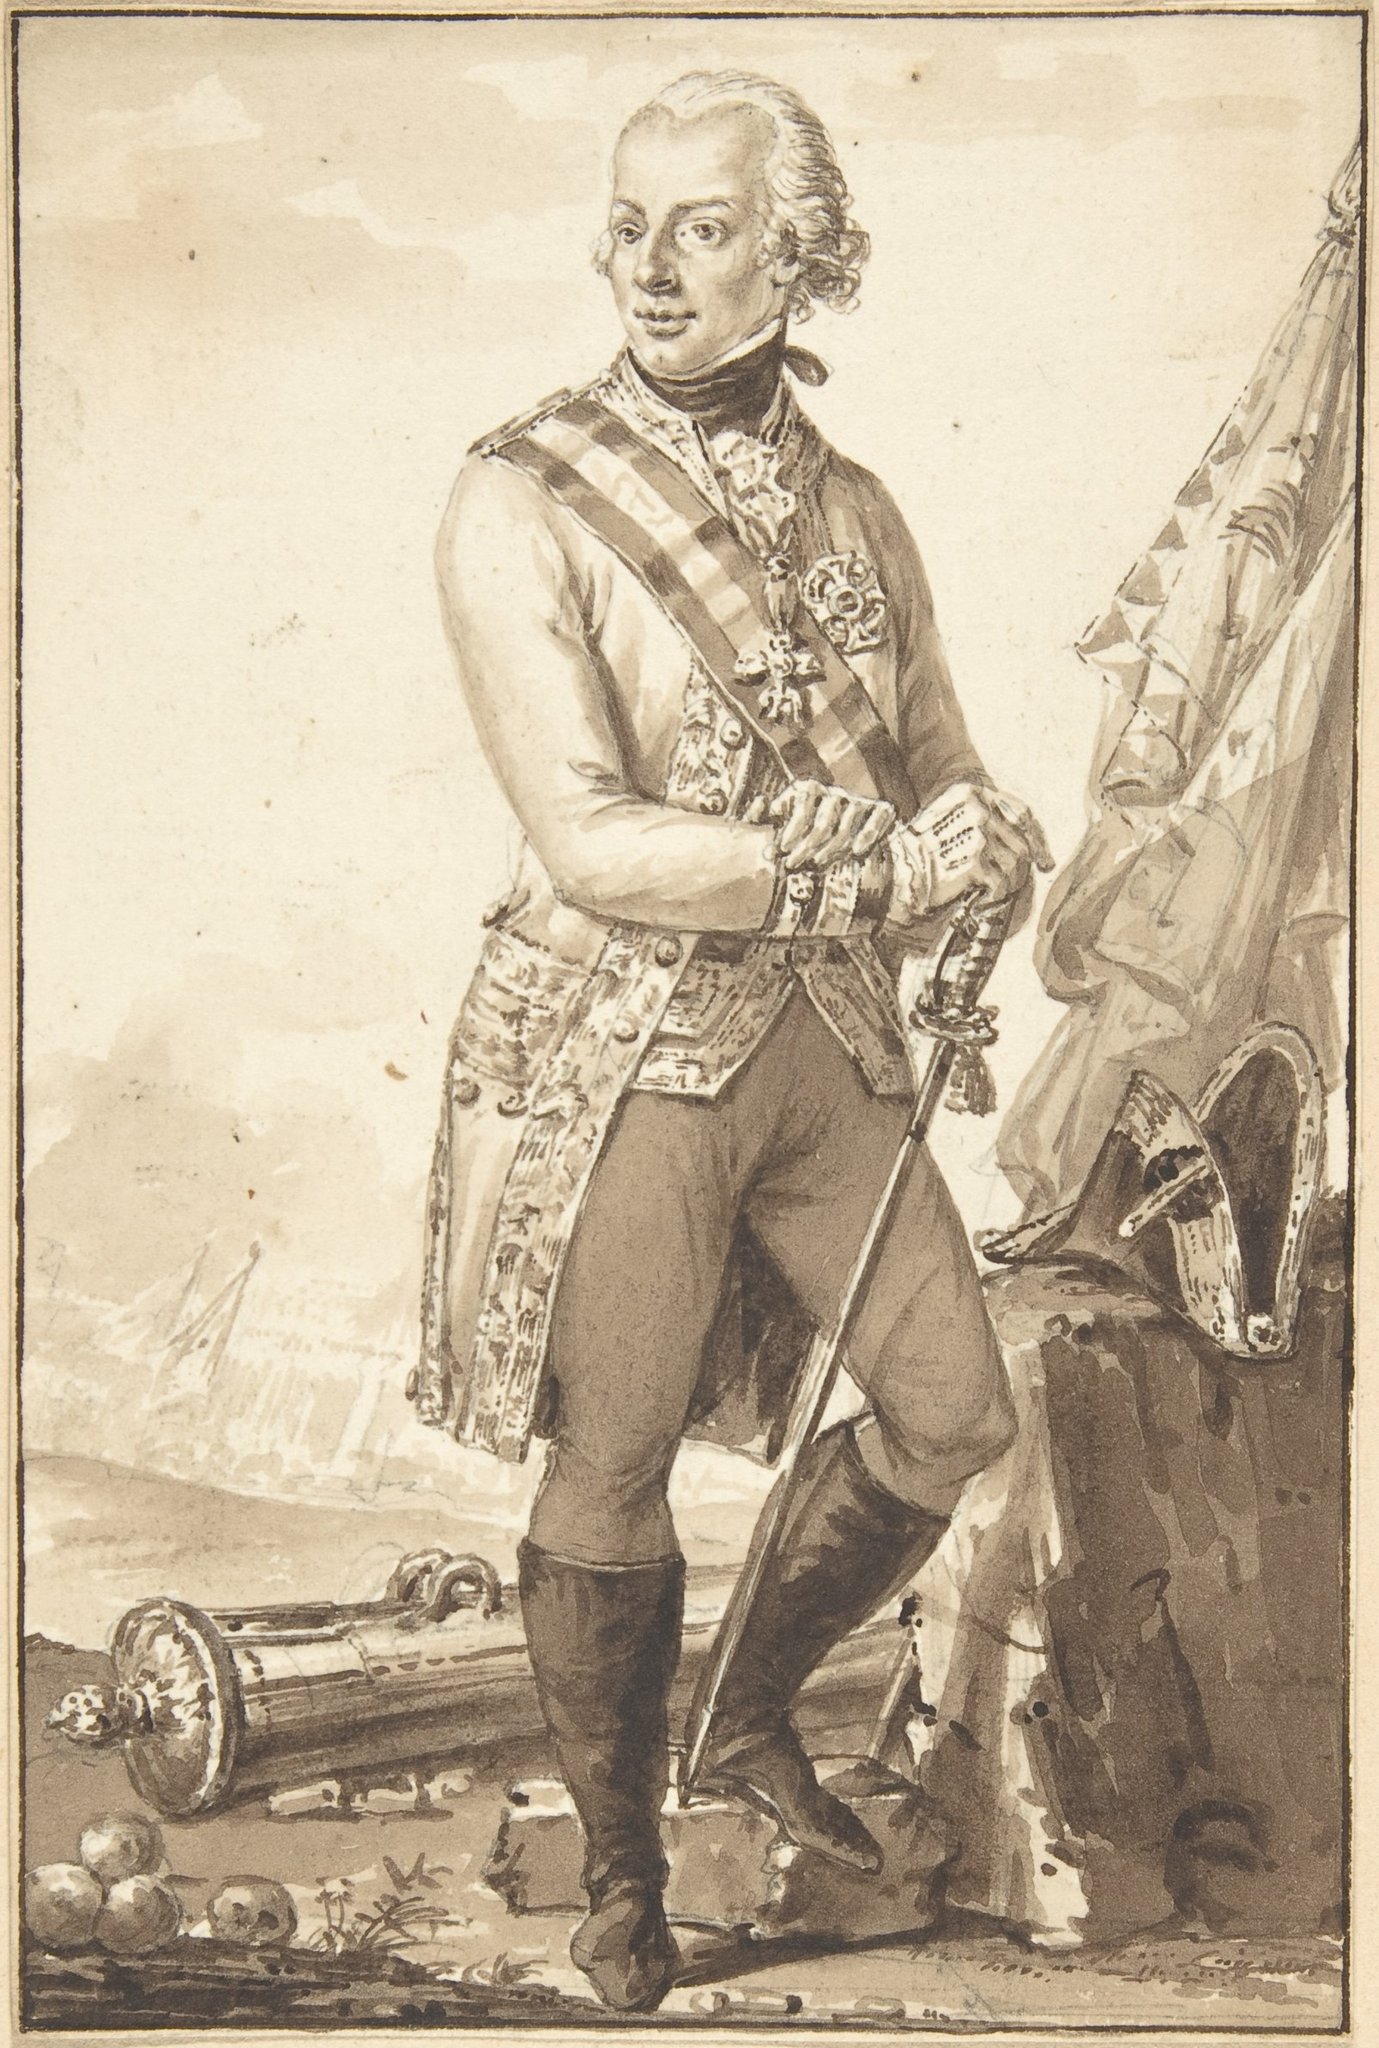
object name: drawing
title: Portrait of Karl Ludwig Johann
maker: jean-baptiste-françois bosio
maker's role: artist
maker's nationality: french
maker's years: 1764-1827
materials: graphite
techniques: brush, wash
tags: swords,men,portraits